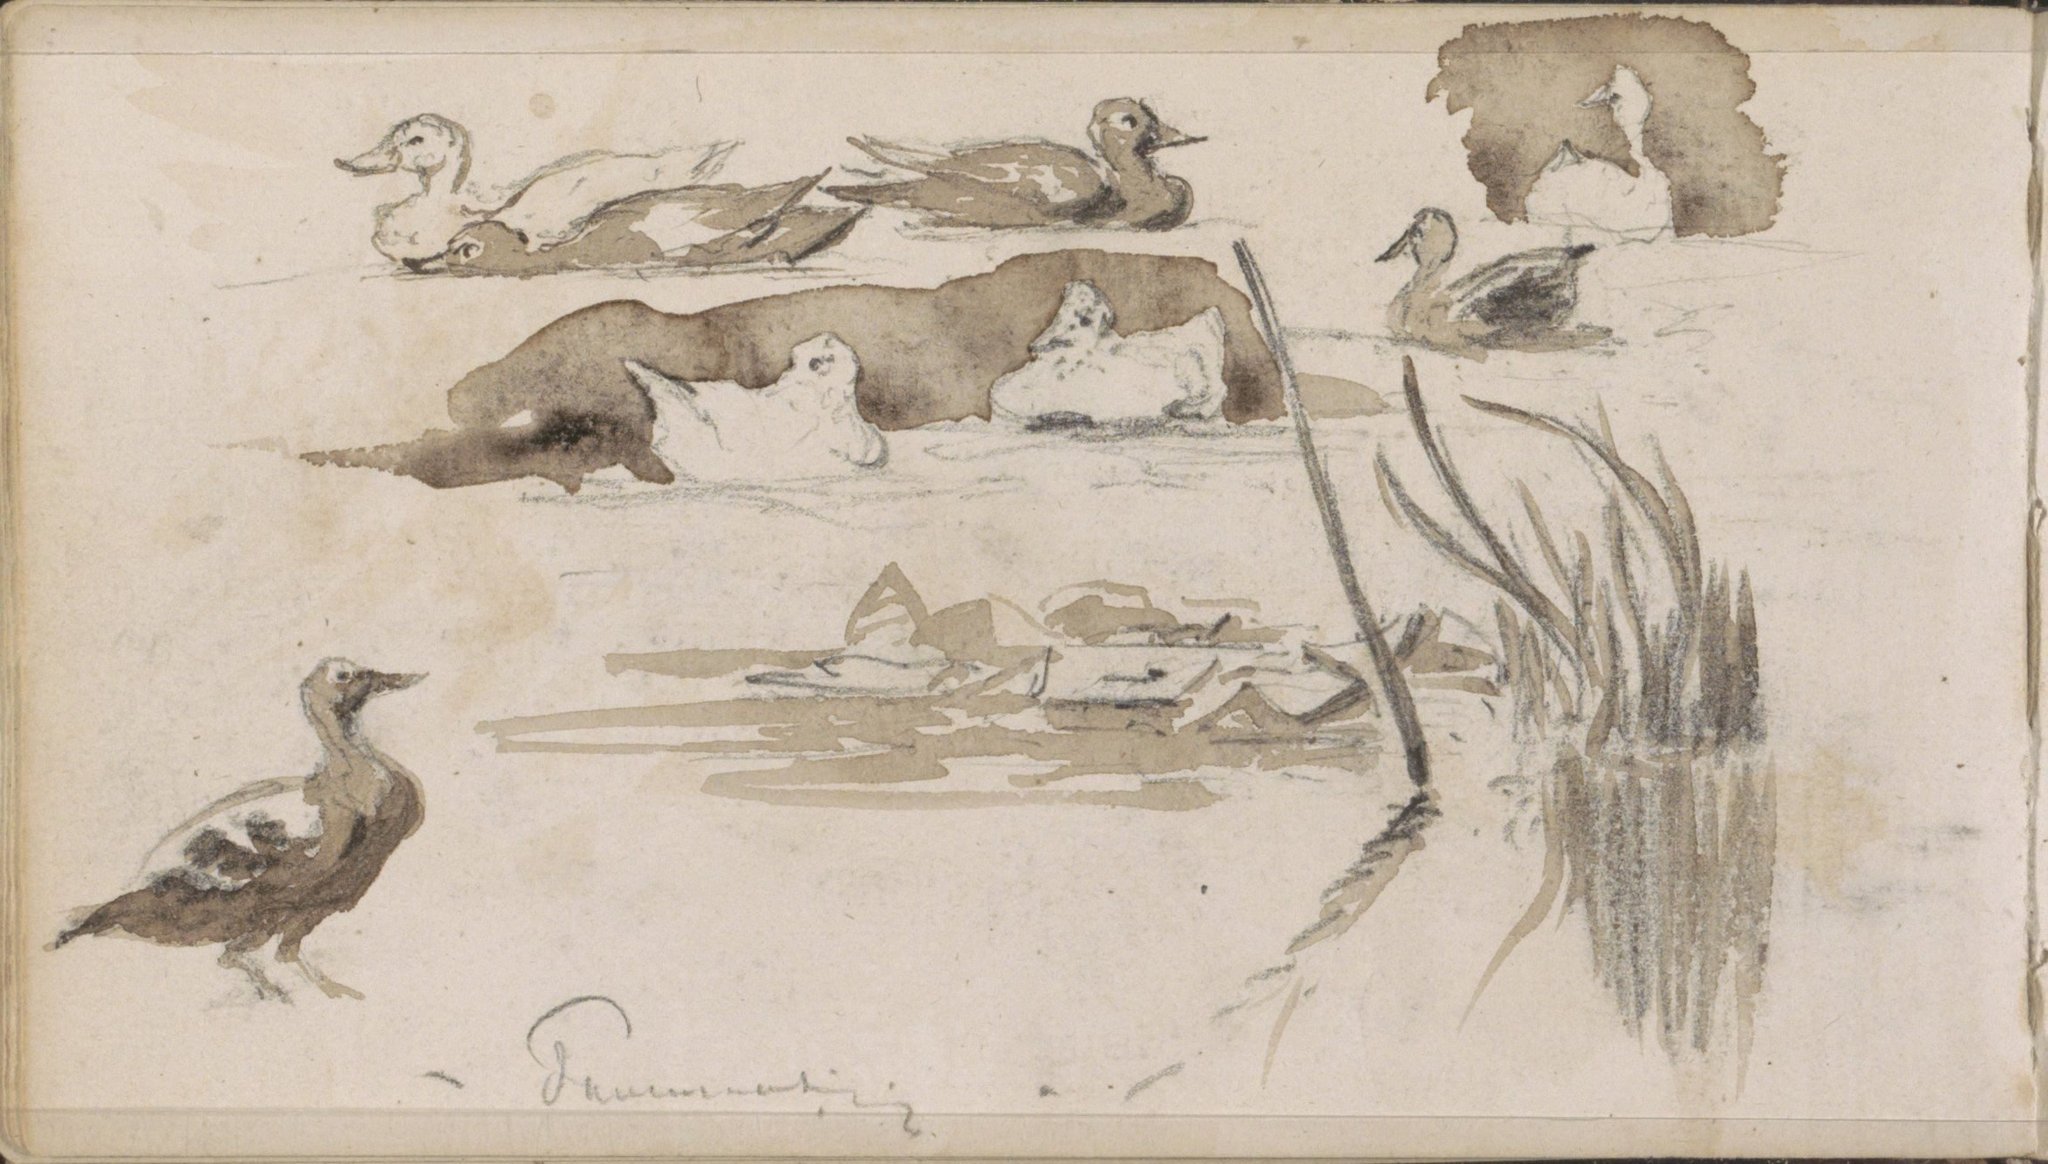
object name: sketchbook leaf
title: Eenden op het water en rietstengels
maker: johannes tavenraat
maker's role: draughtsman, painter, print maker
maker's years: 1809-1881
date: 1864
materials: ink, paper, pencil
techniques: brush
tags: plants and herbs: reed, water-birds: duck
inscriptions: signature: ‘Tavenraat’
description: Blad 5 verso uit een schetsboek met 98 bladen.